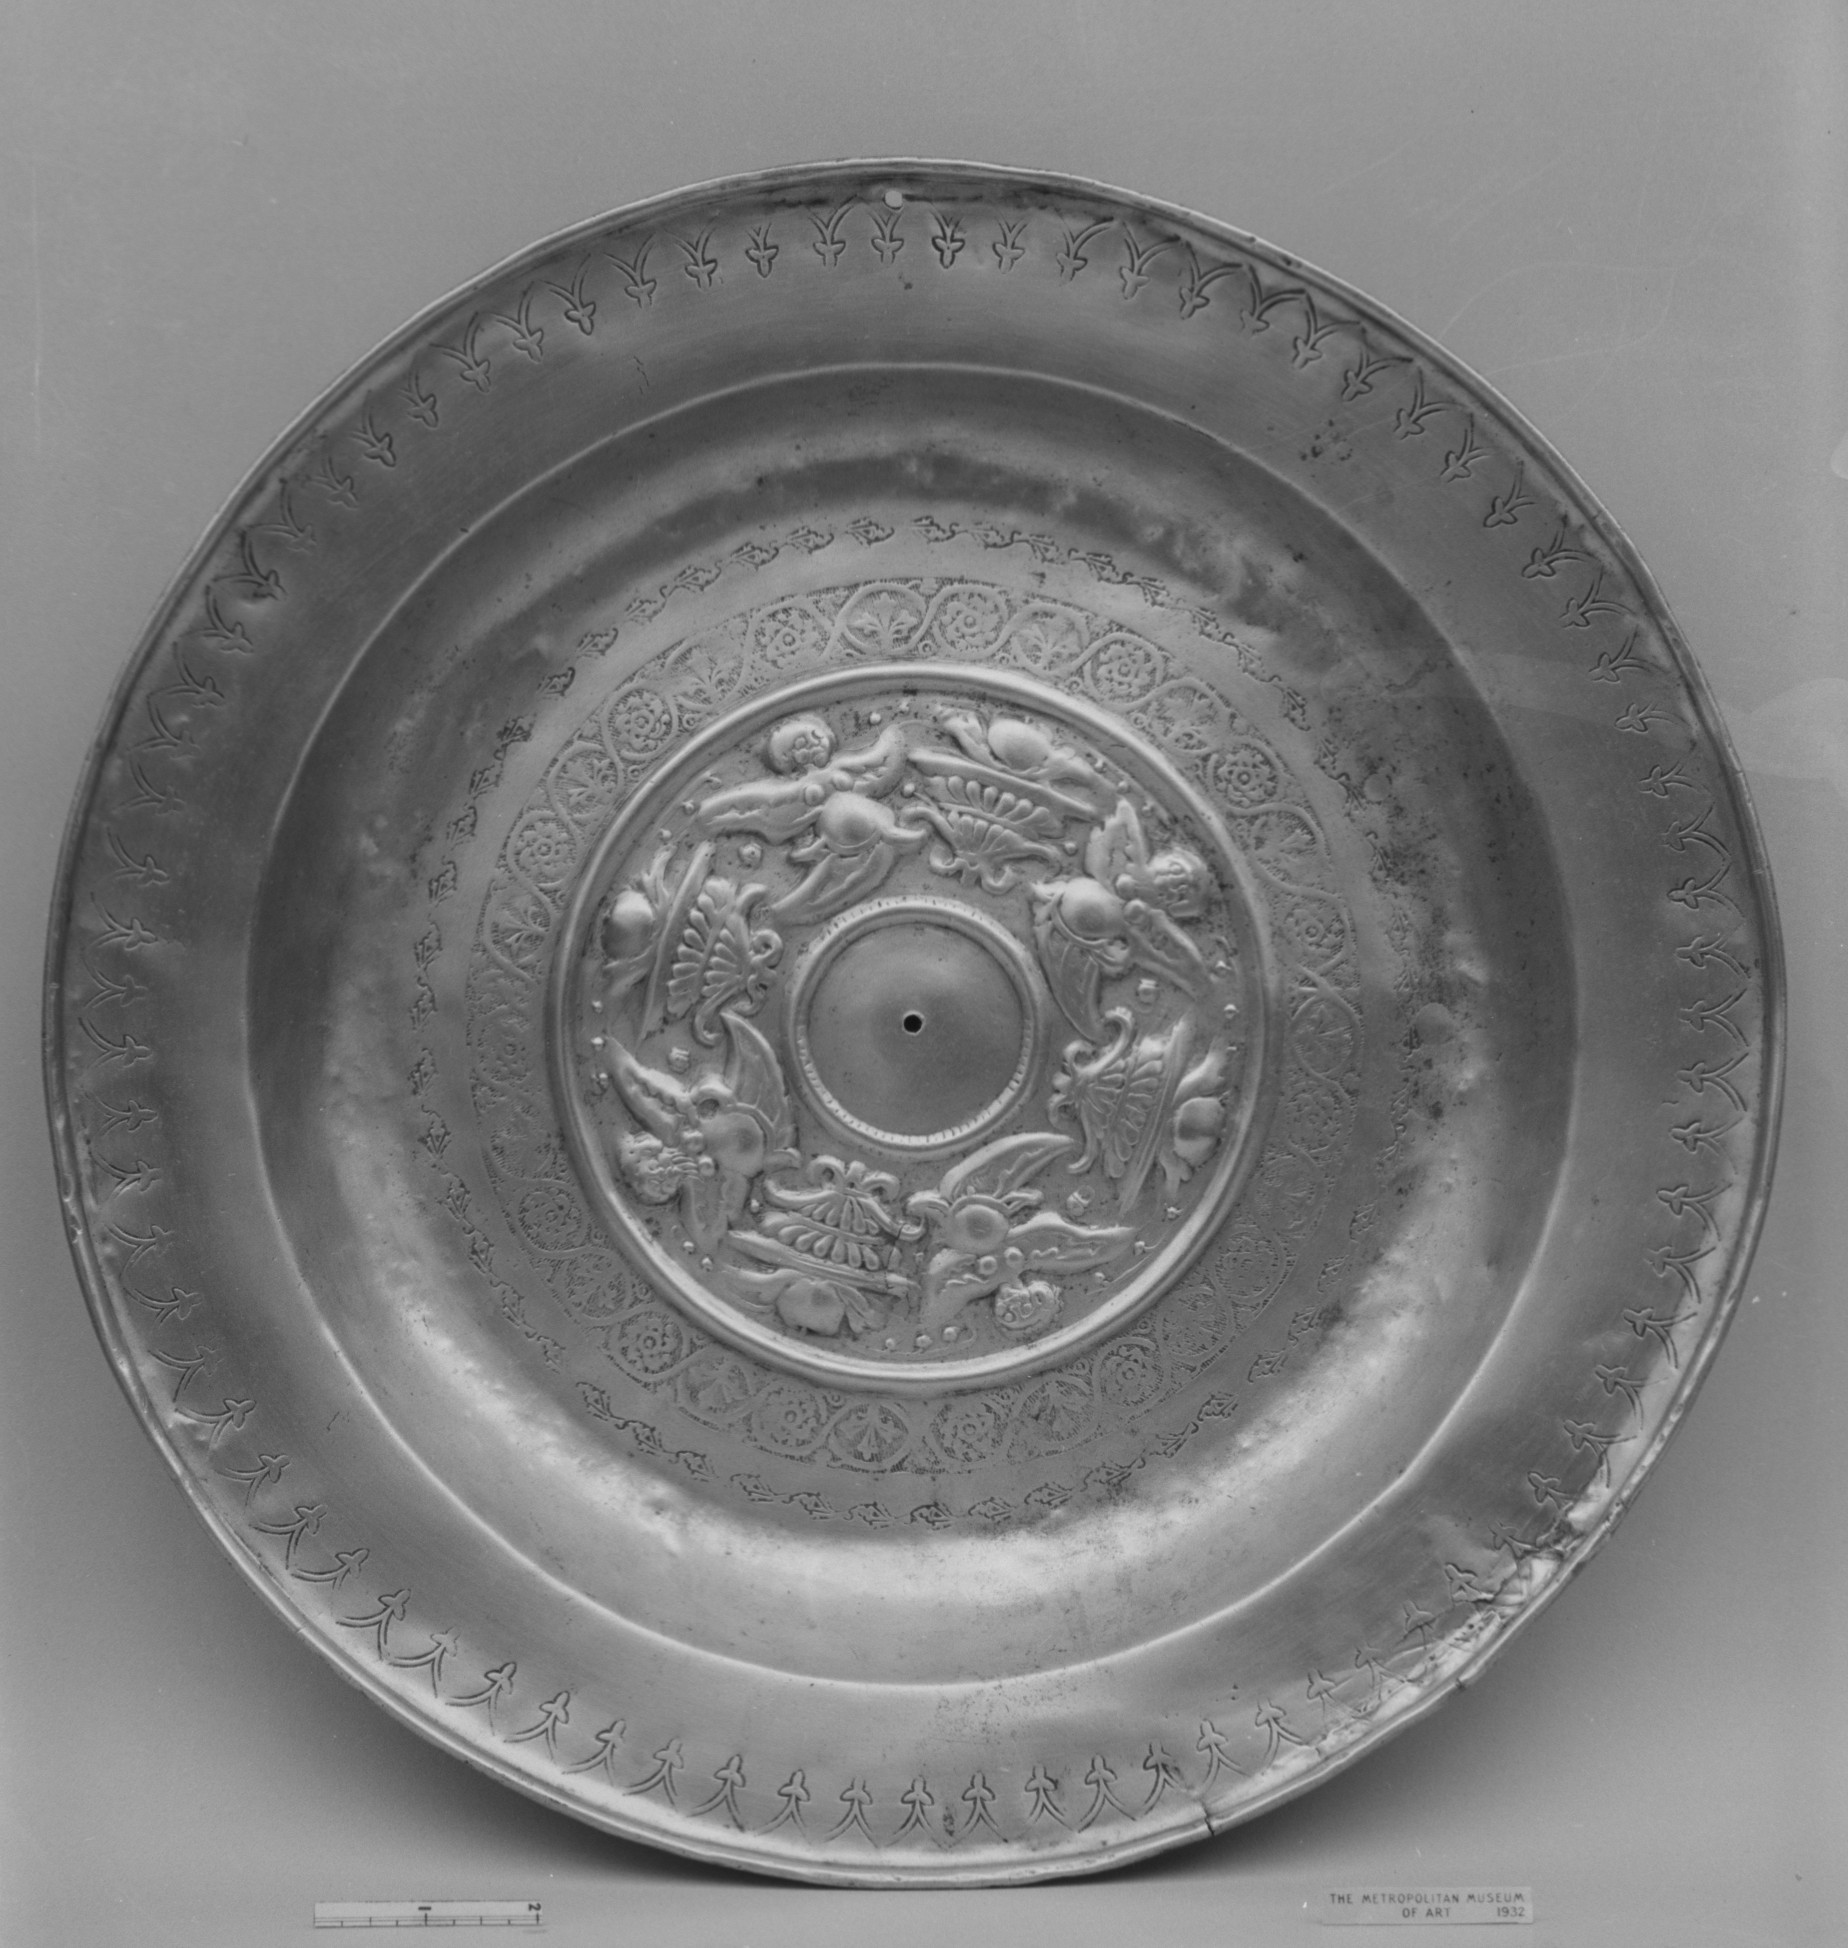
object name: dish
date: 1501-1533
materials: brass